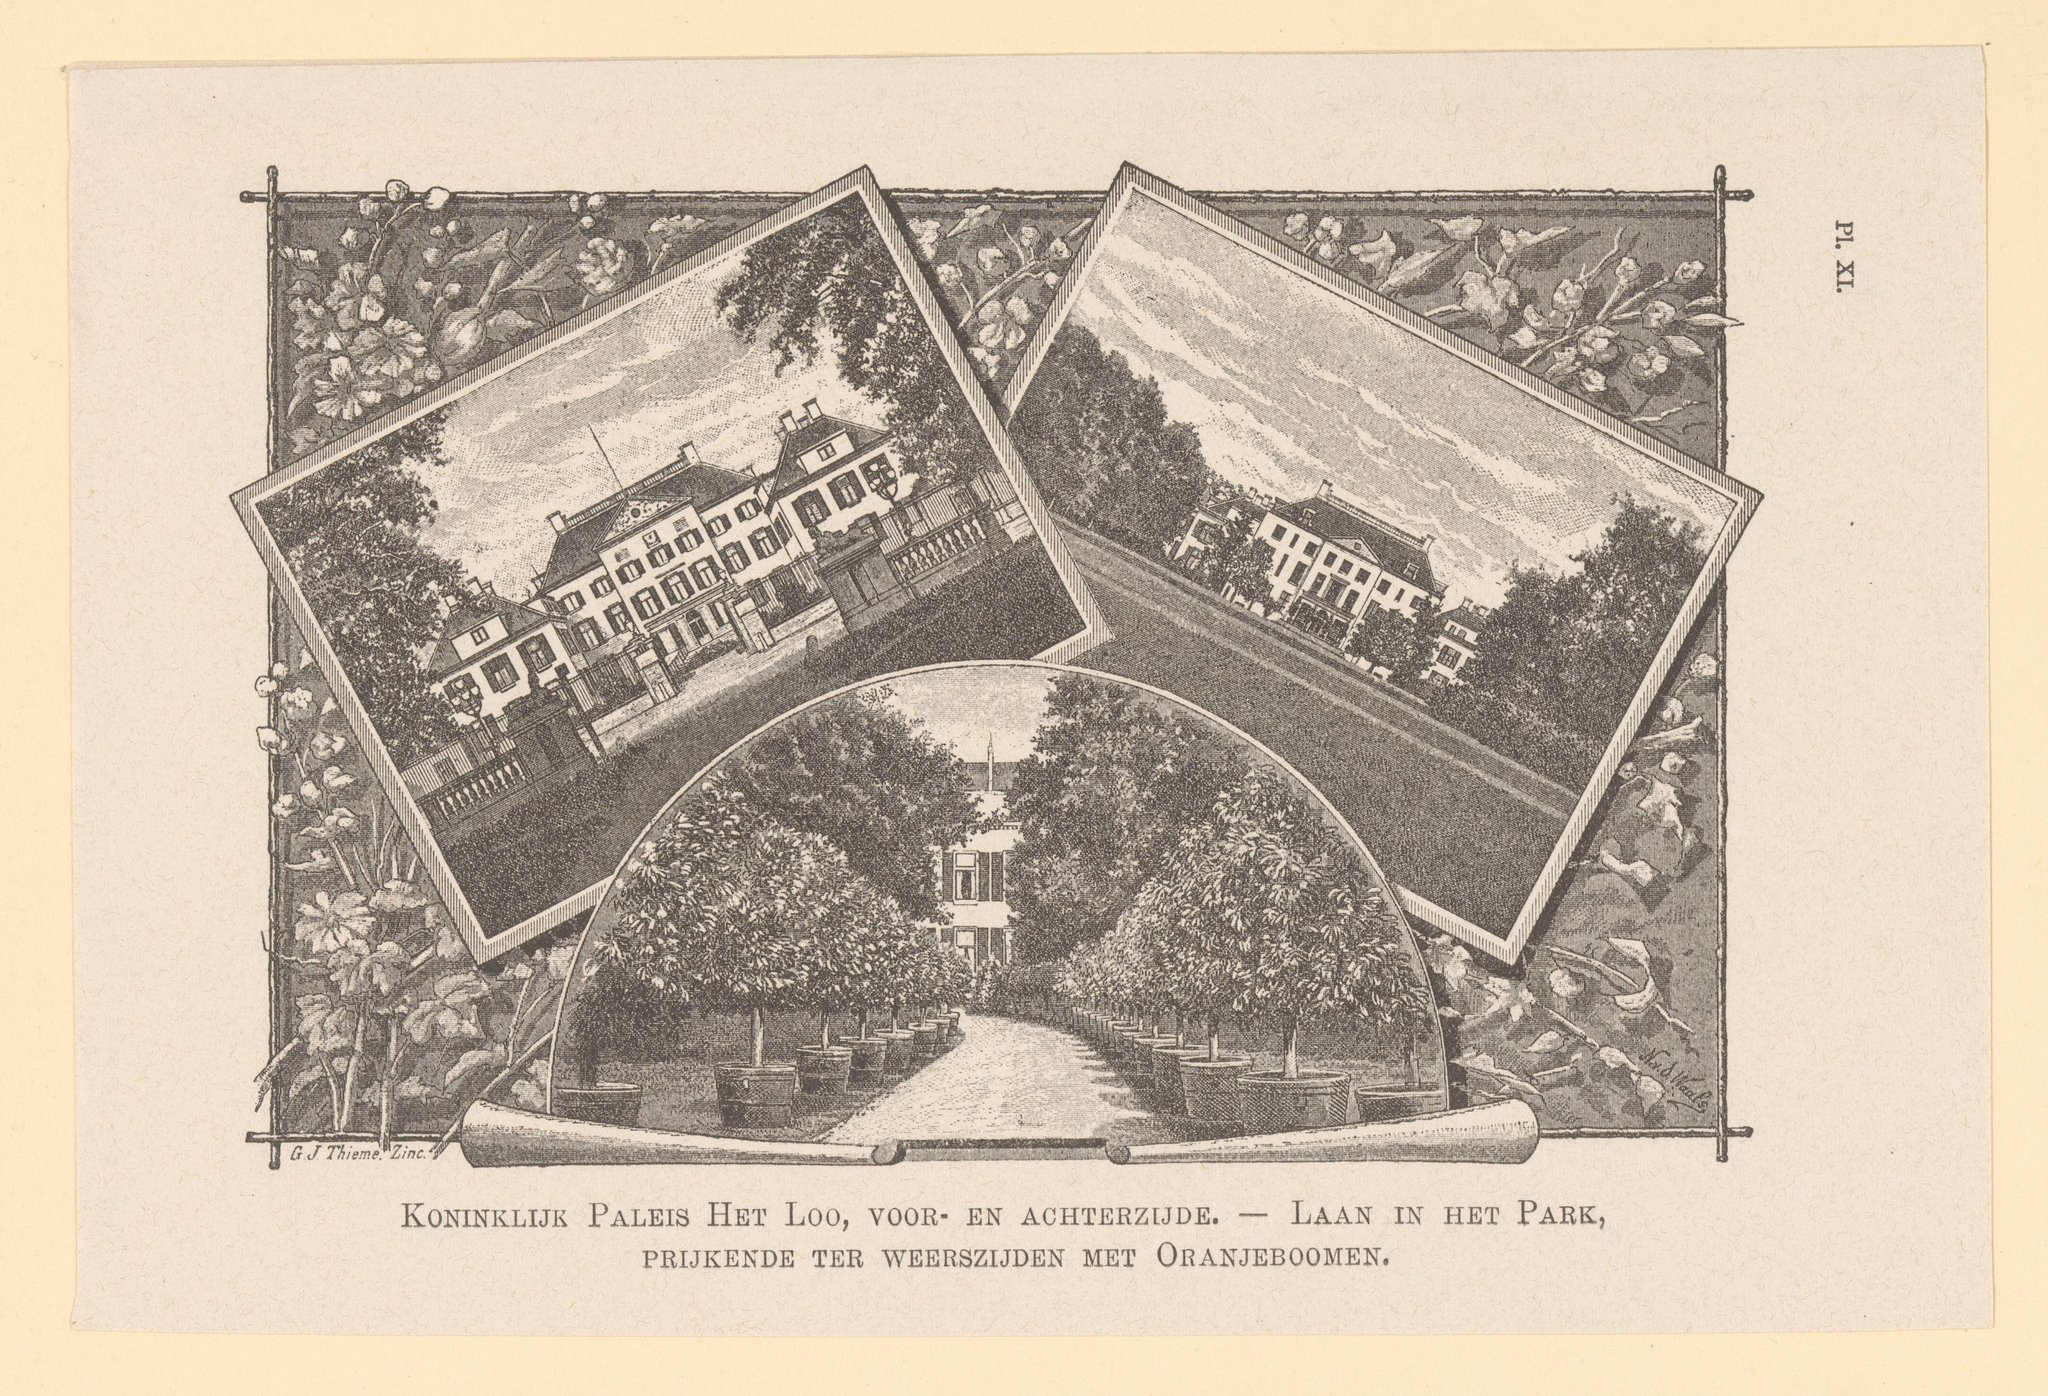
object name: photomechanical print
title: Gezichten op Apeldoorn en omstreken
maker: noach van der waals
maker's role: print maker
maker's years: 1852-1930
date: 1890-1900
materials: paper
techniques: autotype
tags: palace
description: Prent mogelijk uit: Gids voor Apeldoorn en omstreken. Apeldoorn: Vereeniging tot veraangenaming van het verblijf te Apeldoorn, [1891-1897].